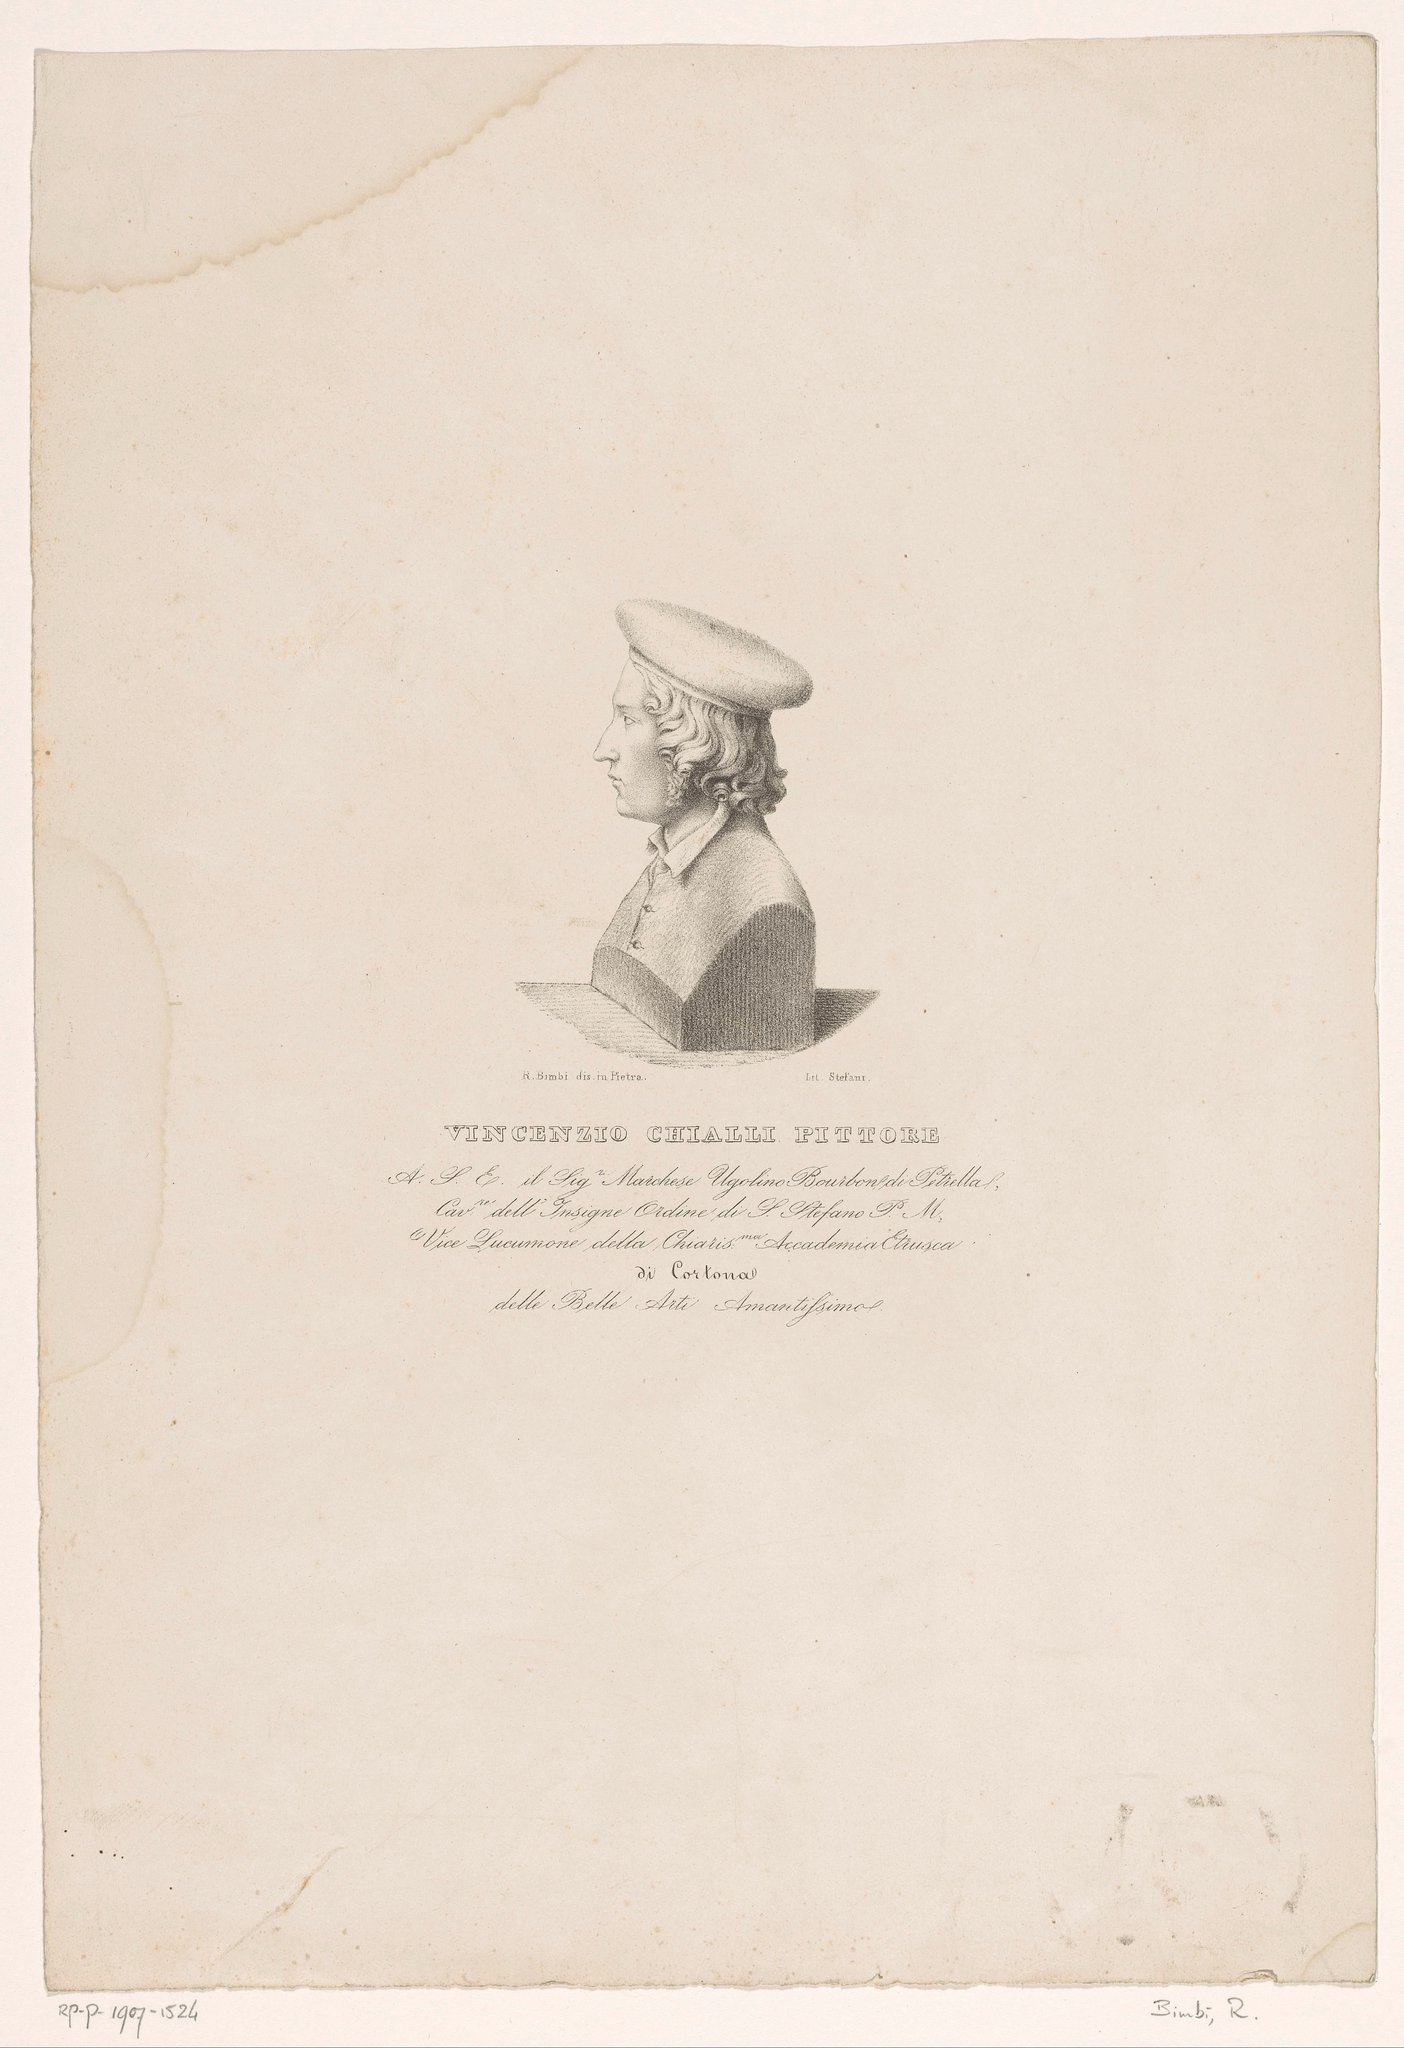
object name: print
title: Portret van schilder Vincenzio Chialli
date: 1800-1899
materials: paper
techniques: lithograph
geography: italy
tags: painter, historical persons, portrait, self-portrait of artist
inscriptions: collector's mark: Lugt 2228